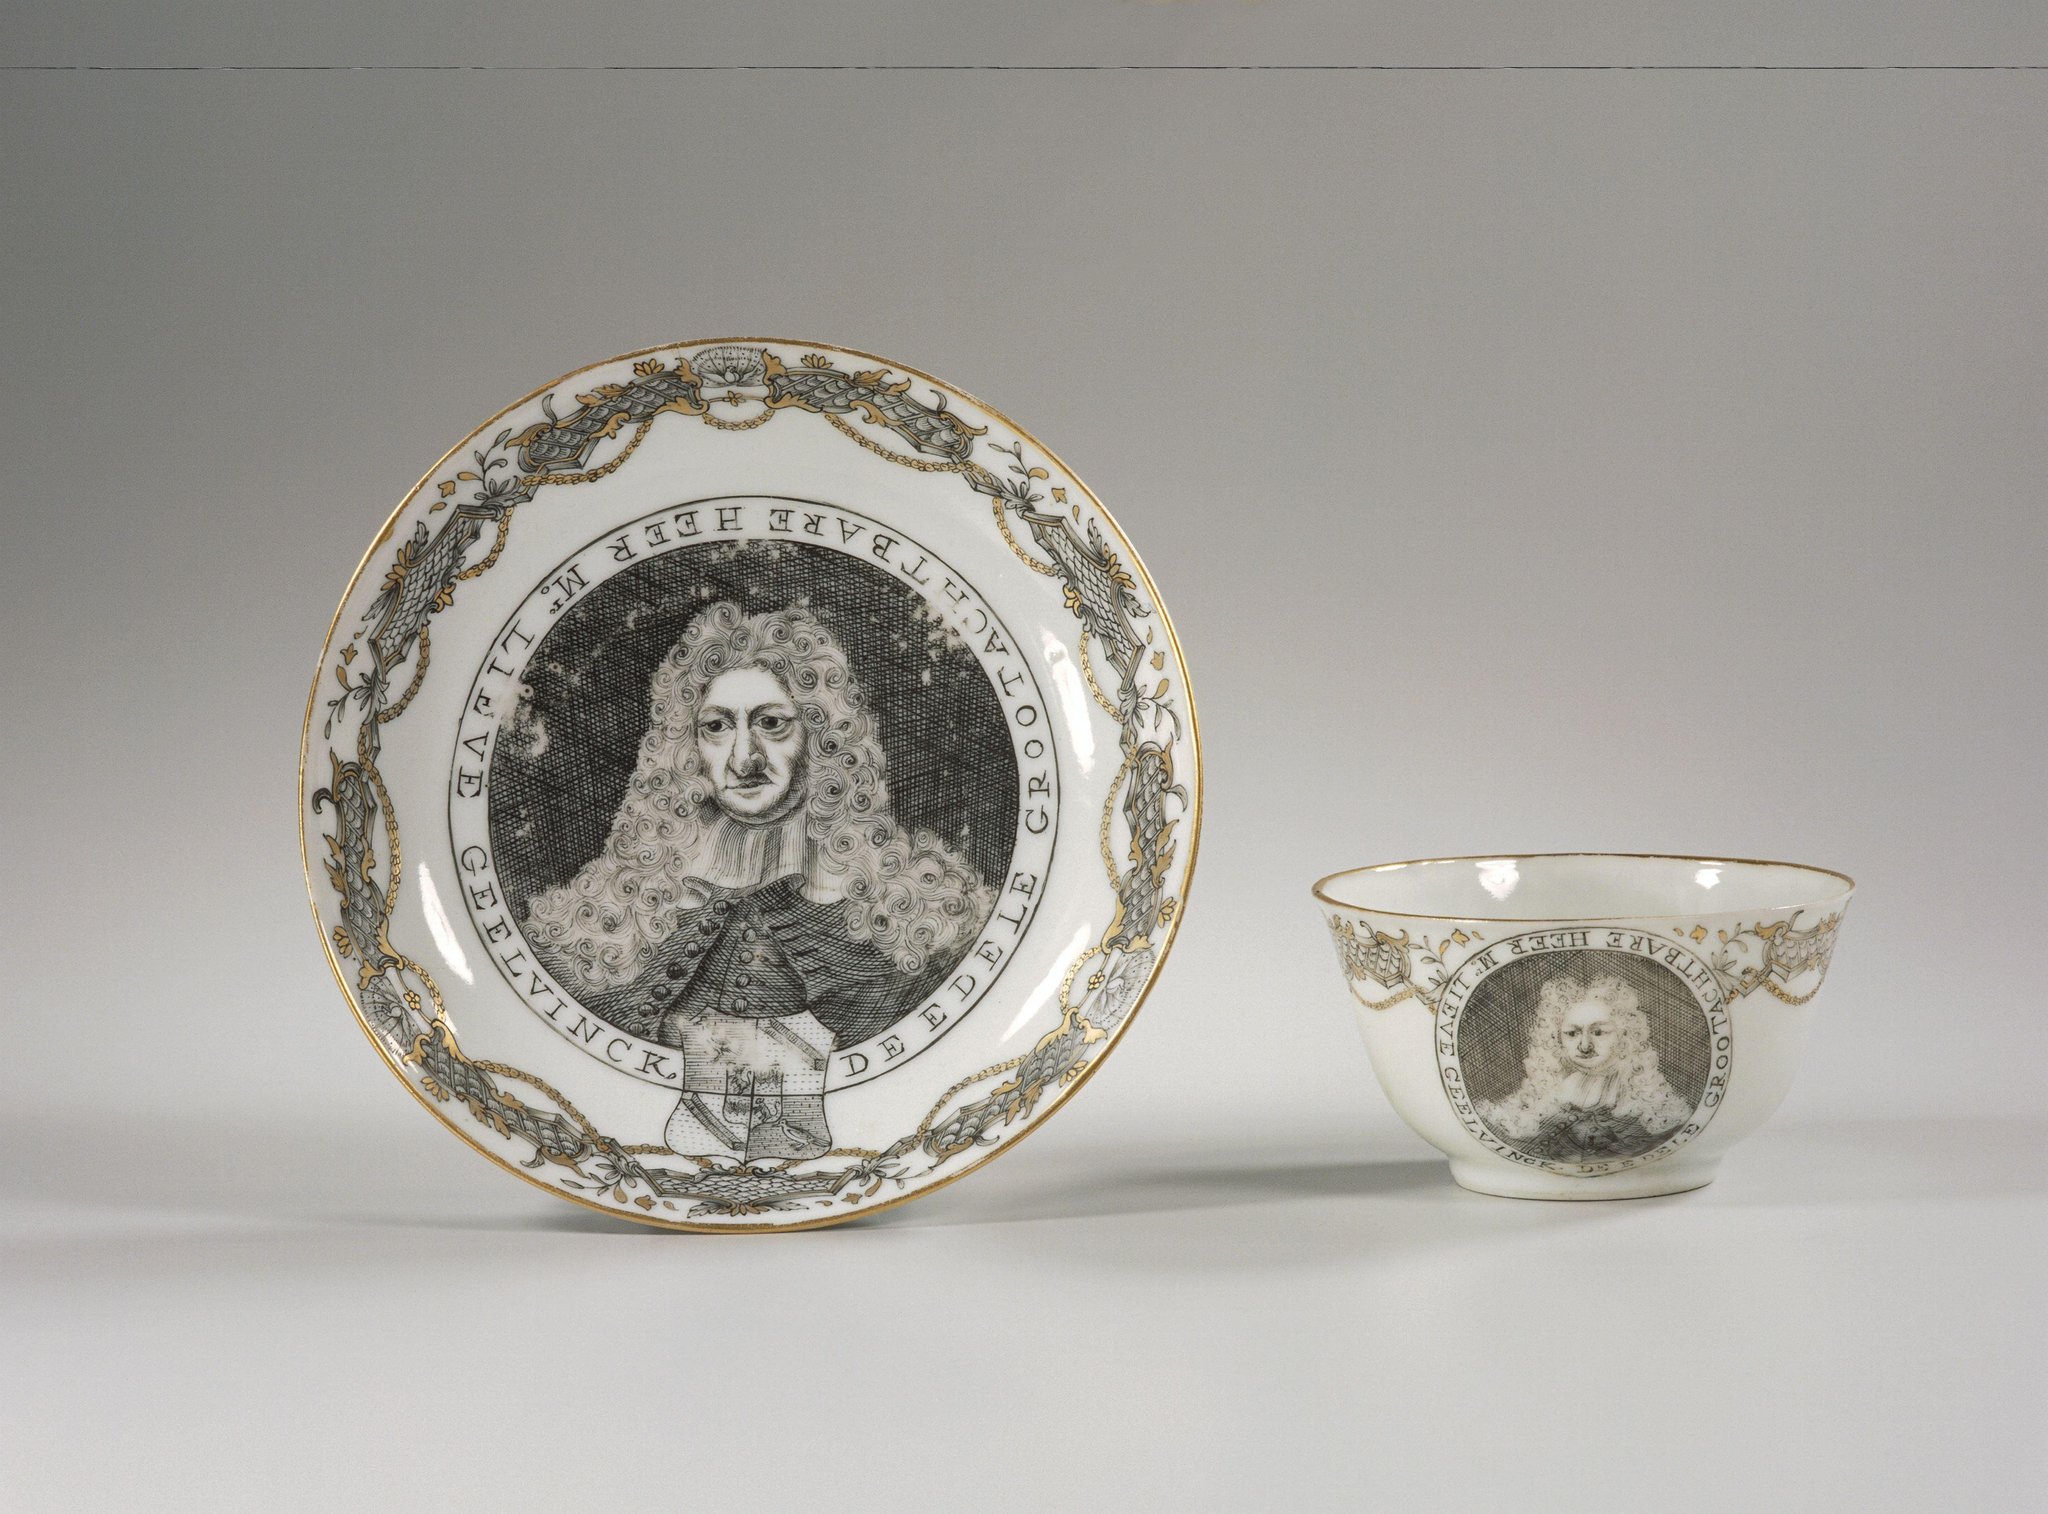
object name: platter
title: Saucer with a portrait of Lieve Geelvinck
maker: Anonymous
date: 1760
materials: glaze, gold, paint, porcelain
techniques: firing, gilding, turning, vitrification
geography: china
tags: amsterdam, mayor, lieve geelvinck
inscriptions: inscription: ‘DE EDELE GROOTACHTBARE HEER Mr. LIEVE GEELVINCK’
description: Het portret is een nauwkeurige kopie naar een gravure uit 1758 door Jacob Houbraken (1698-1780) en gebaseerd op een schilderij van Jan Wandelaar (1690-1759). Geelvinck was naast burgemeester van Amsterdam ook één van de directeuren van de VOC. Dit bood hem een uitstekende gelegenheid om Chine de commande porselein in China te laten vervaardigen. Hij bezat eveneens een polychroom servies voorzien van zijn wapen. Ook is een bord bekend met een allegorische voorstelling op zijn huwelijk met Jacoba Graafland in 1729. (C.J.A. Jörg en Jan van Campen, Chinese Ceramics in the Rijksmuseum, Londen 1997, p. 280)